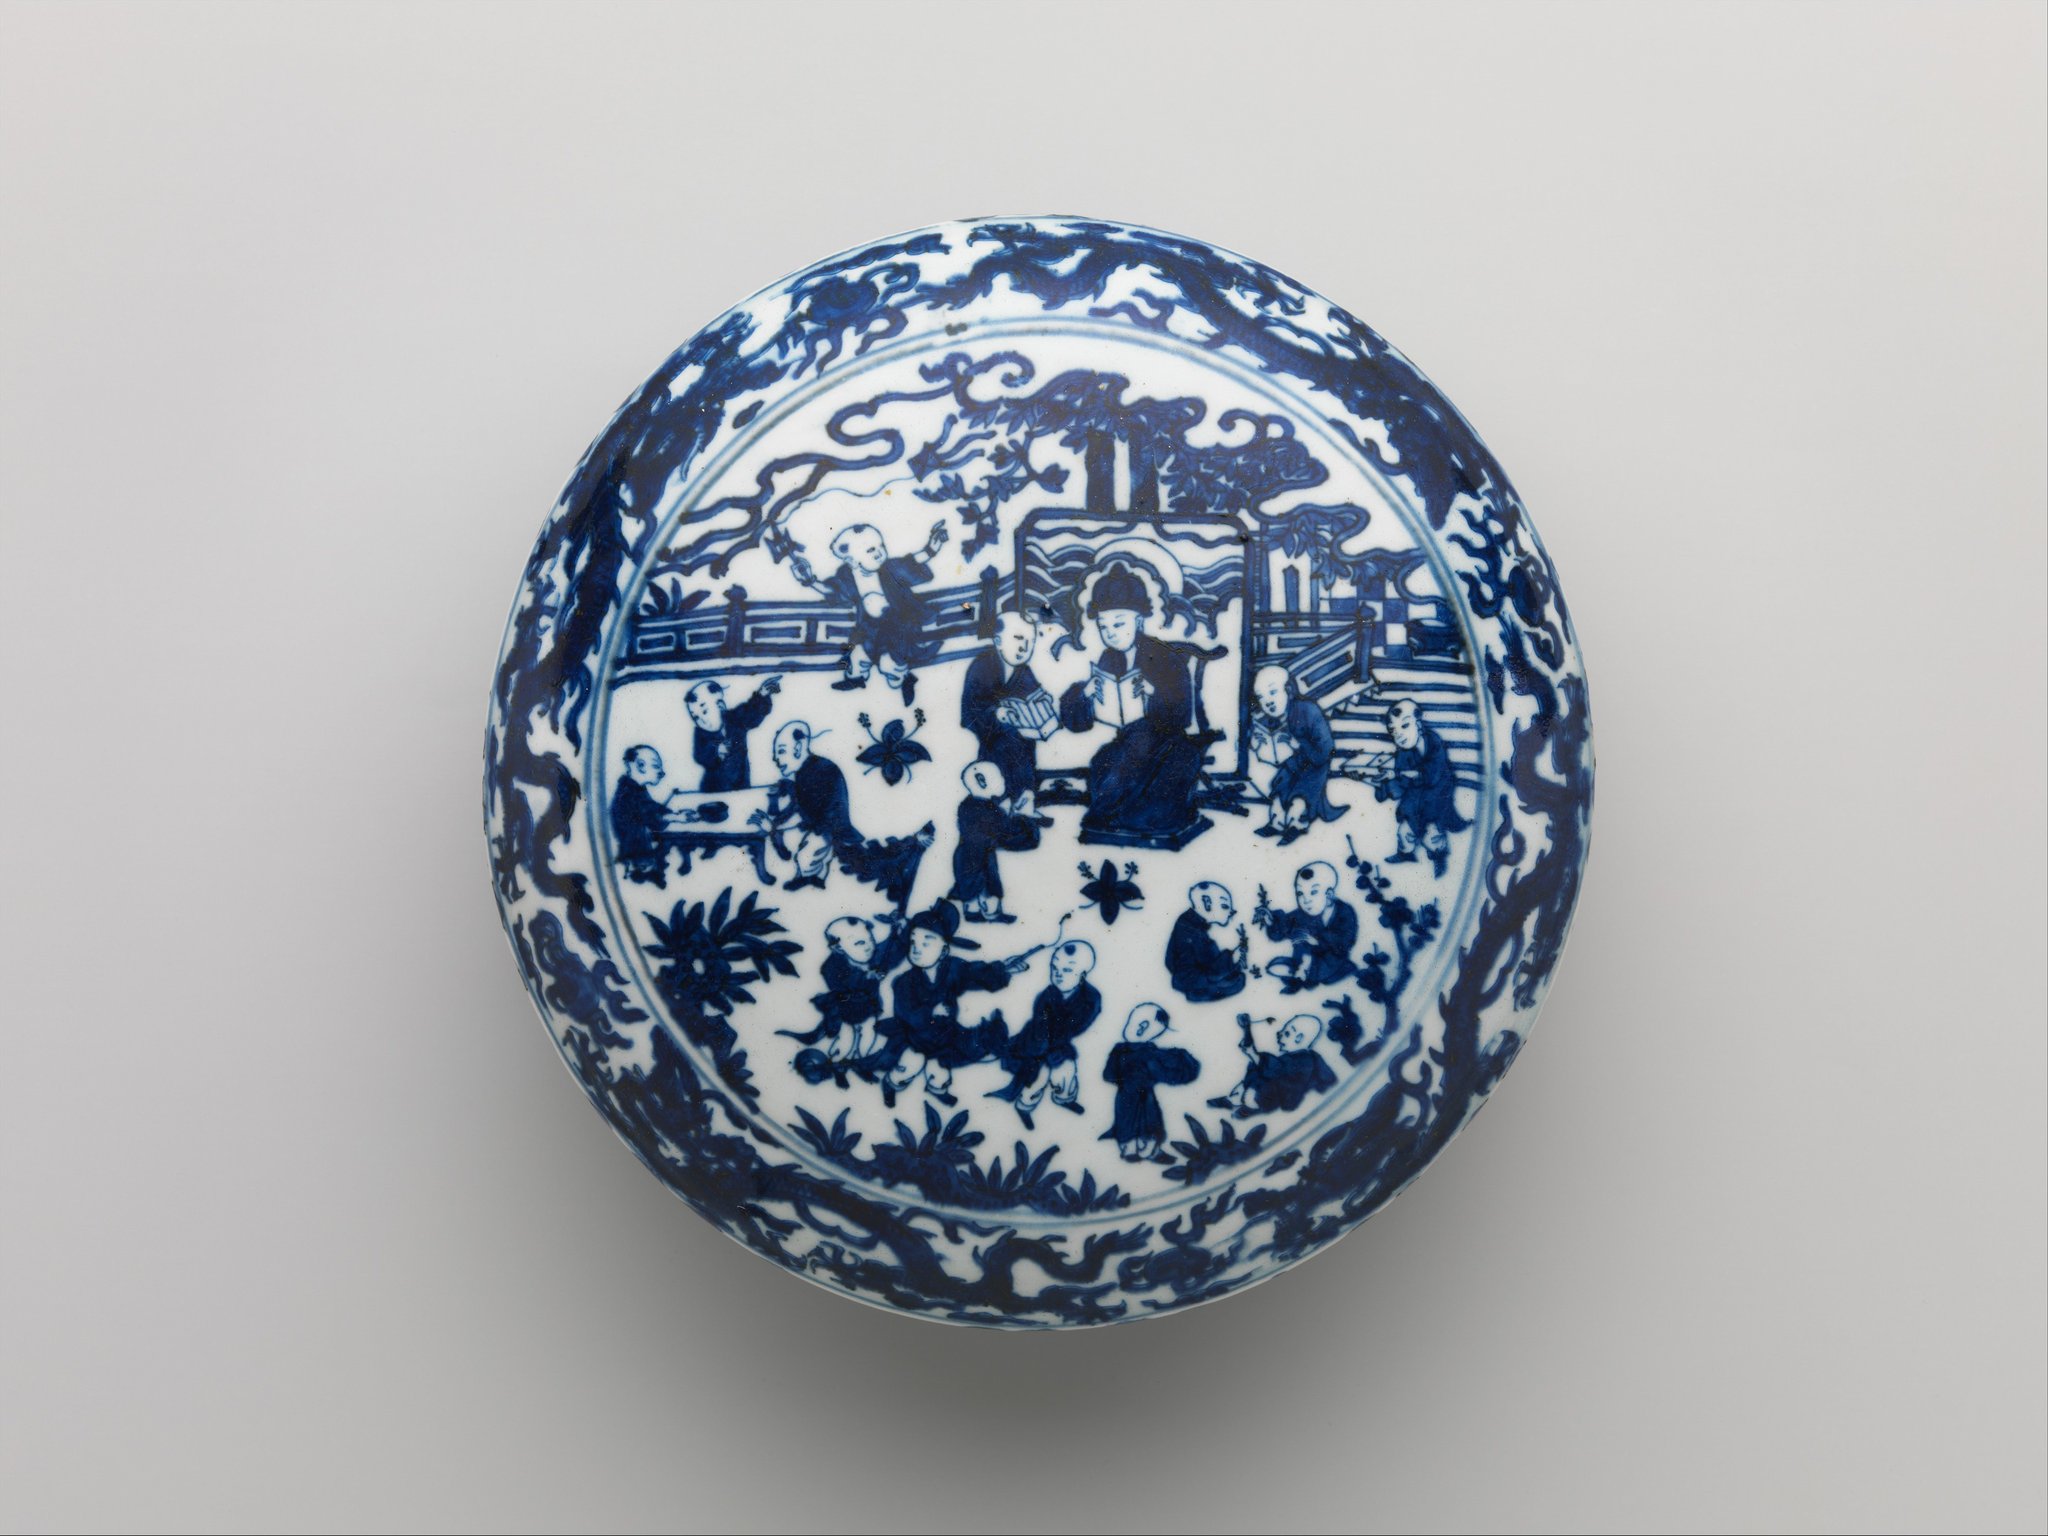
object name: covered box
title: Box with Boys Playing in Garden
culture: chinese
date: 1567-1633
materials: cobalt, glaze, porcelain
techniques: painting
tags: gardens,boys,playing